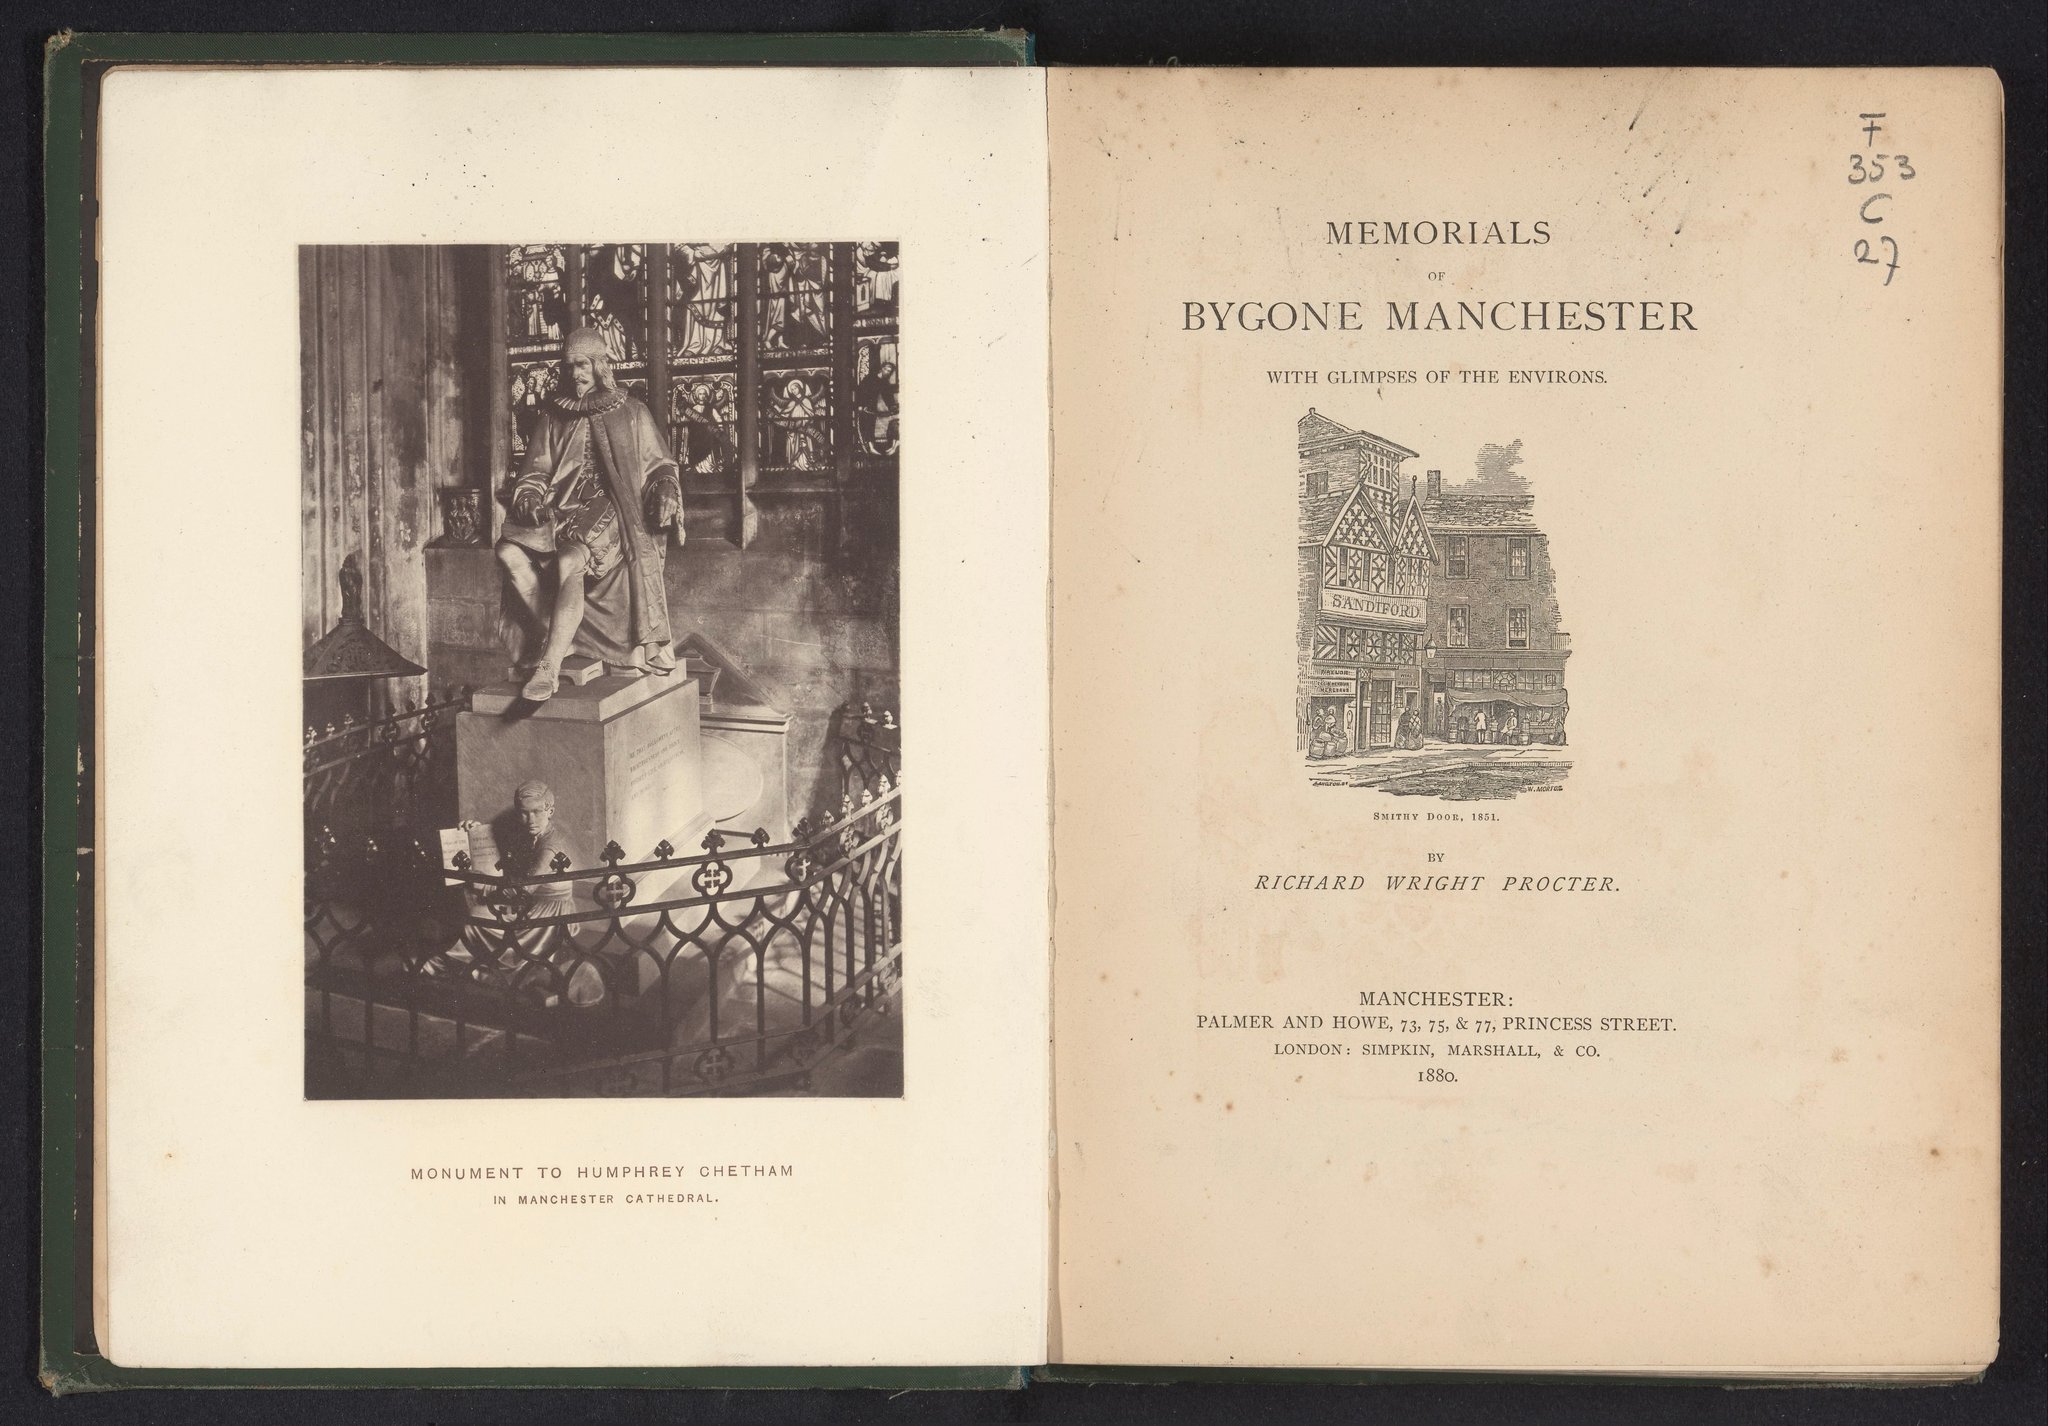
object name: book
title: Memorials of bygone Manchester with glimpses of the environs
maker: richard wright procter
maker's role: bibliothecaris, kapper, schrijver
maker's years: 1816-1881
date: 1880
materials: linen, paper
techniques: photograph, woodburytype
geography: manchester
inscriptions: name: ‘ex libris SFJ’